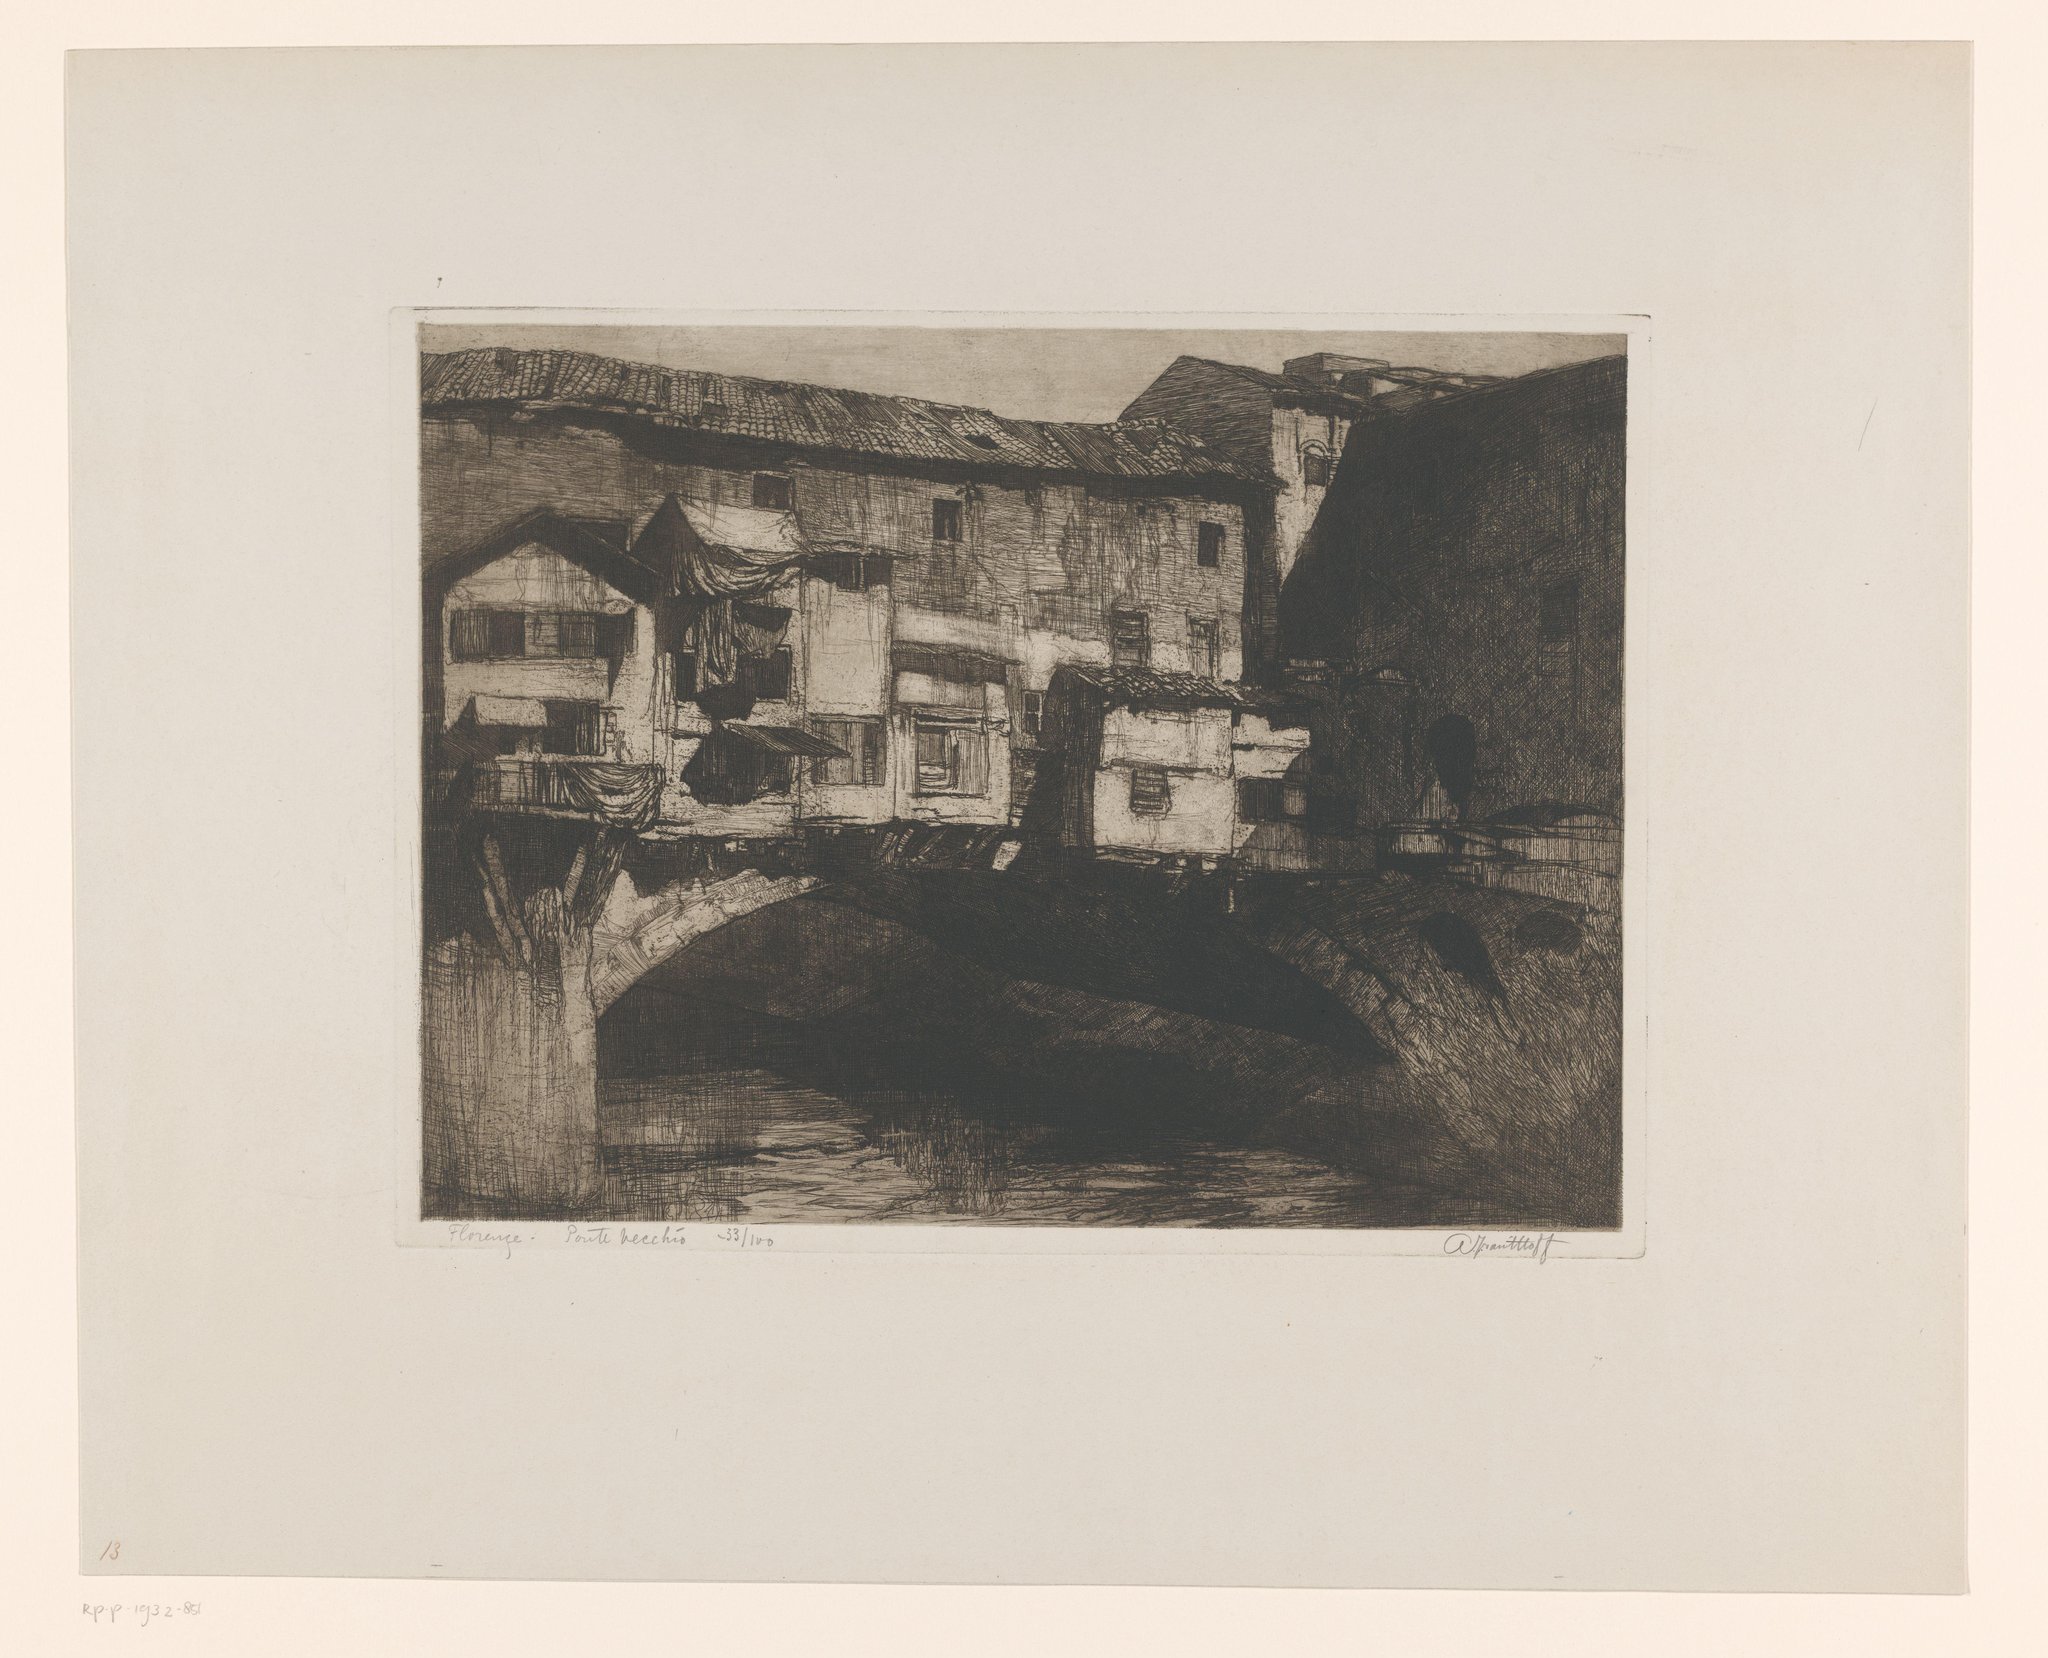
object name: print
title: Florence. Ponte Vecchio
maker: adriaan j. van t hoff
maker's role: draughtsman, print maker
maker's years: 1893-1939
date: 1903-1932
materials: paper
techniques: etching, intaglio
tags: bridge in city across river, canal, etc.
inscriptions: collector's mark: Lugt 2228